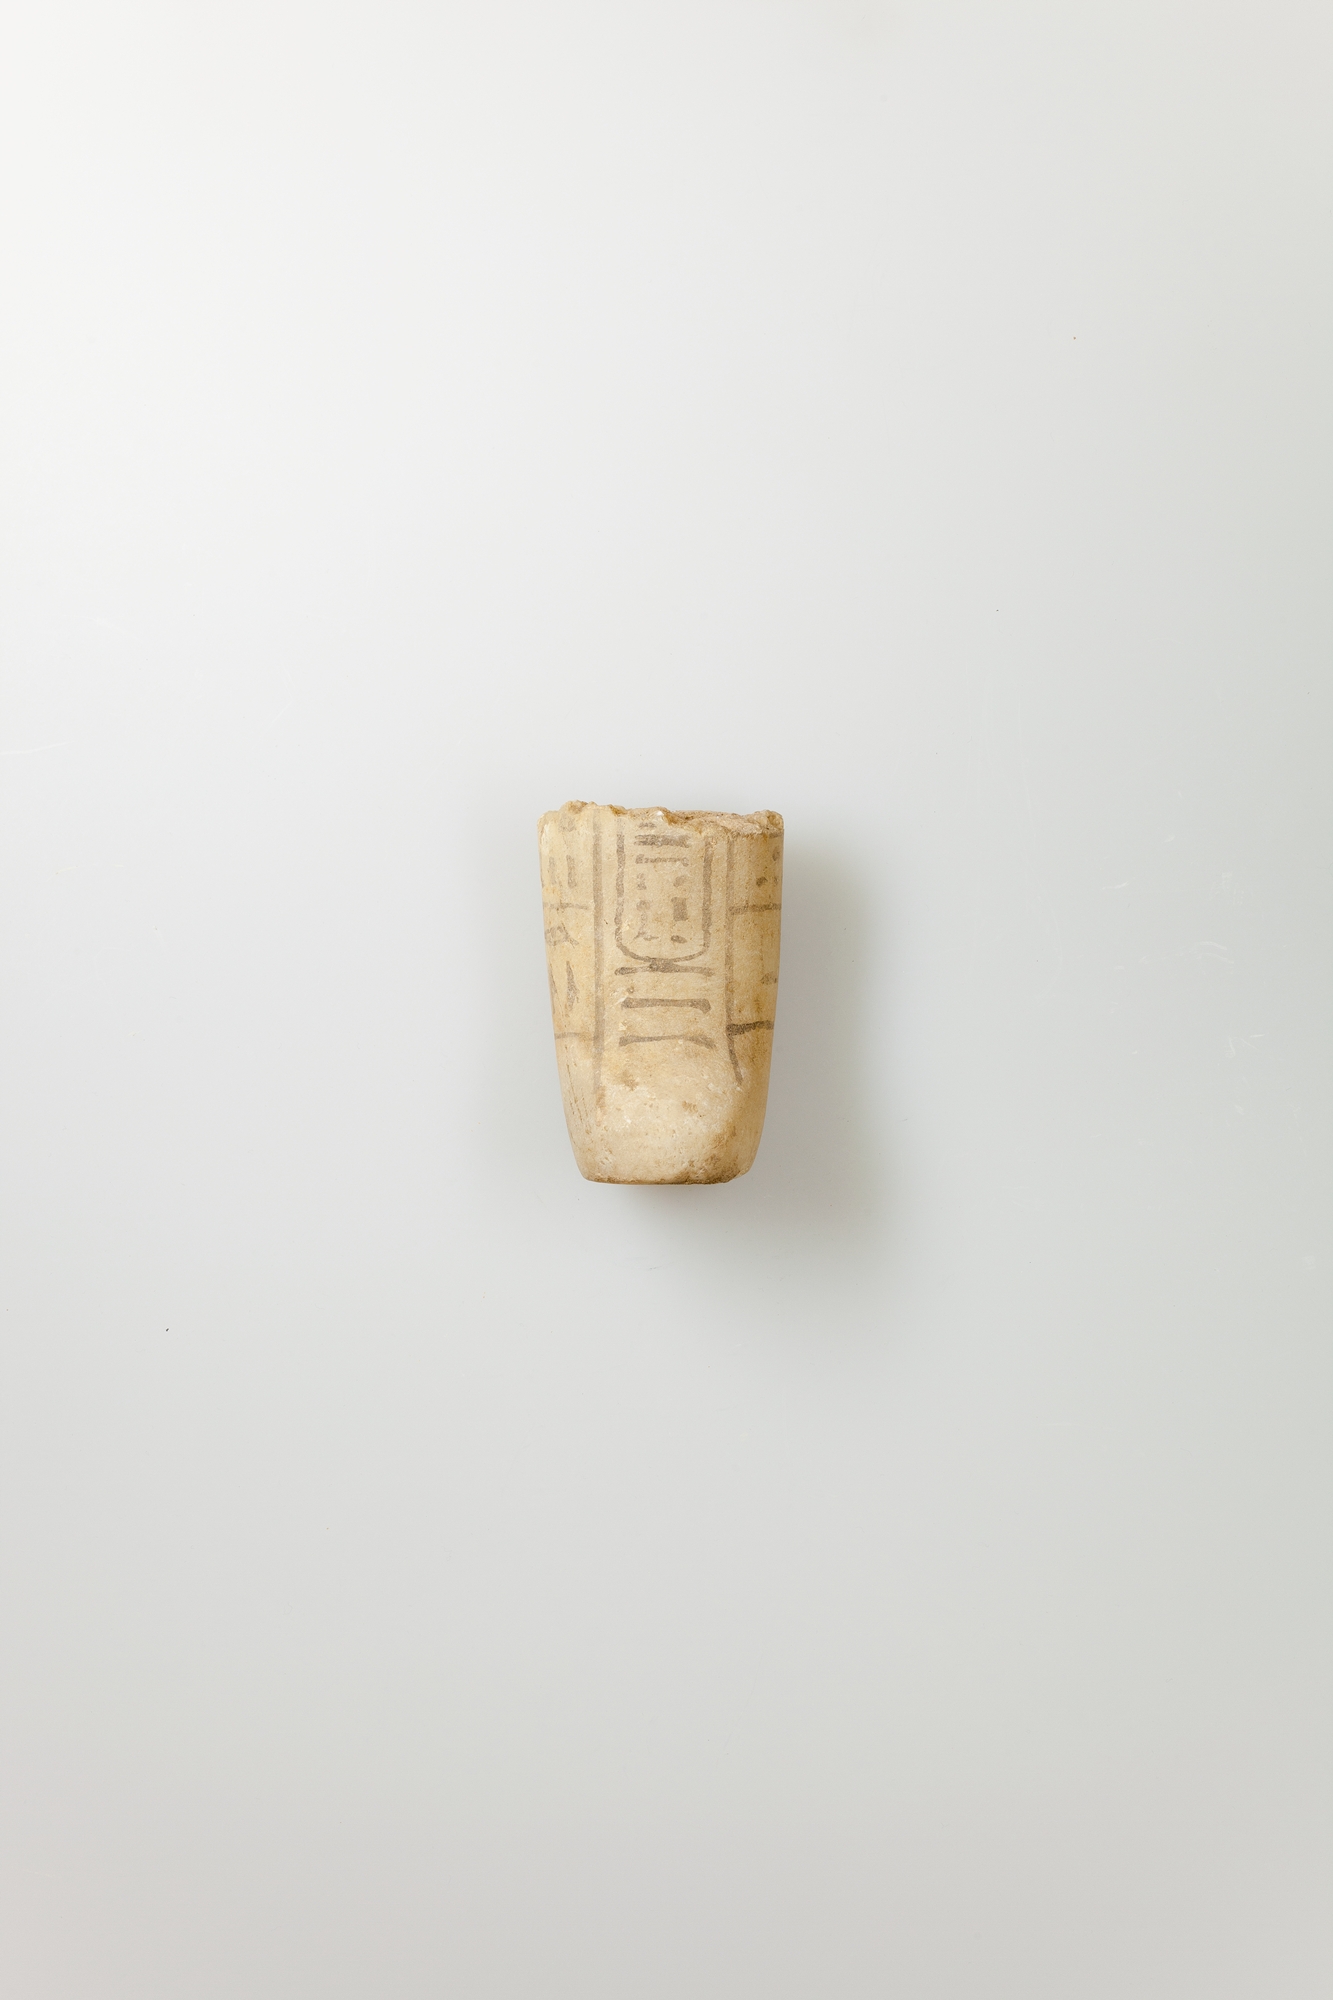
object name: shabti, siptah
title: Shabti of Siptah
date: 1194-1188 BCE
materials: stone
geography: egypt